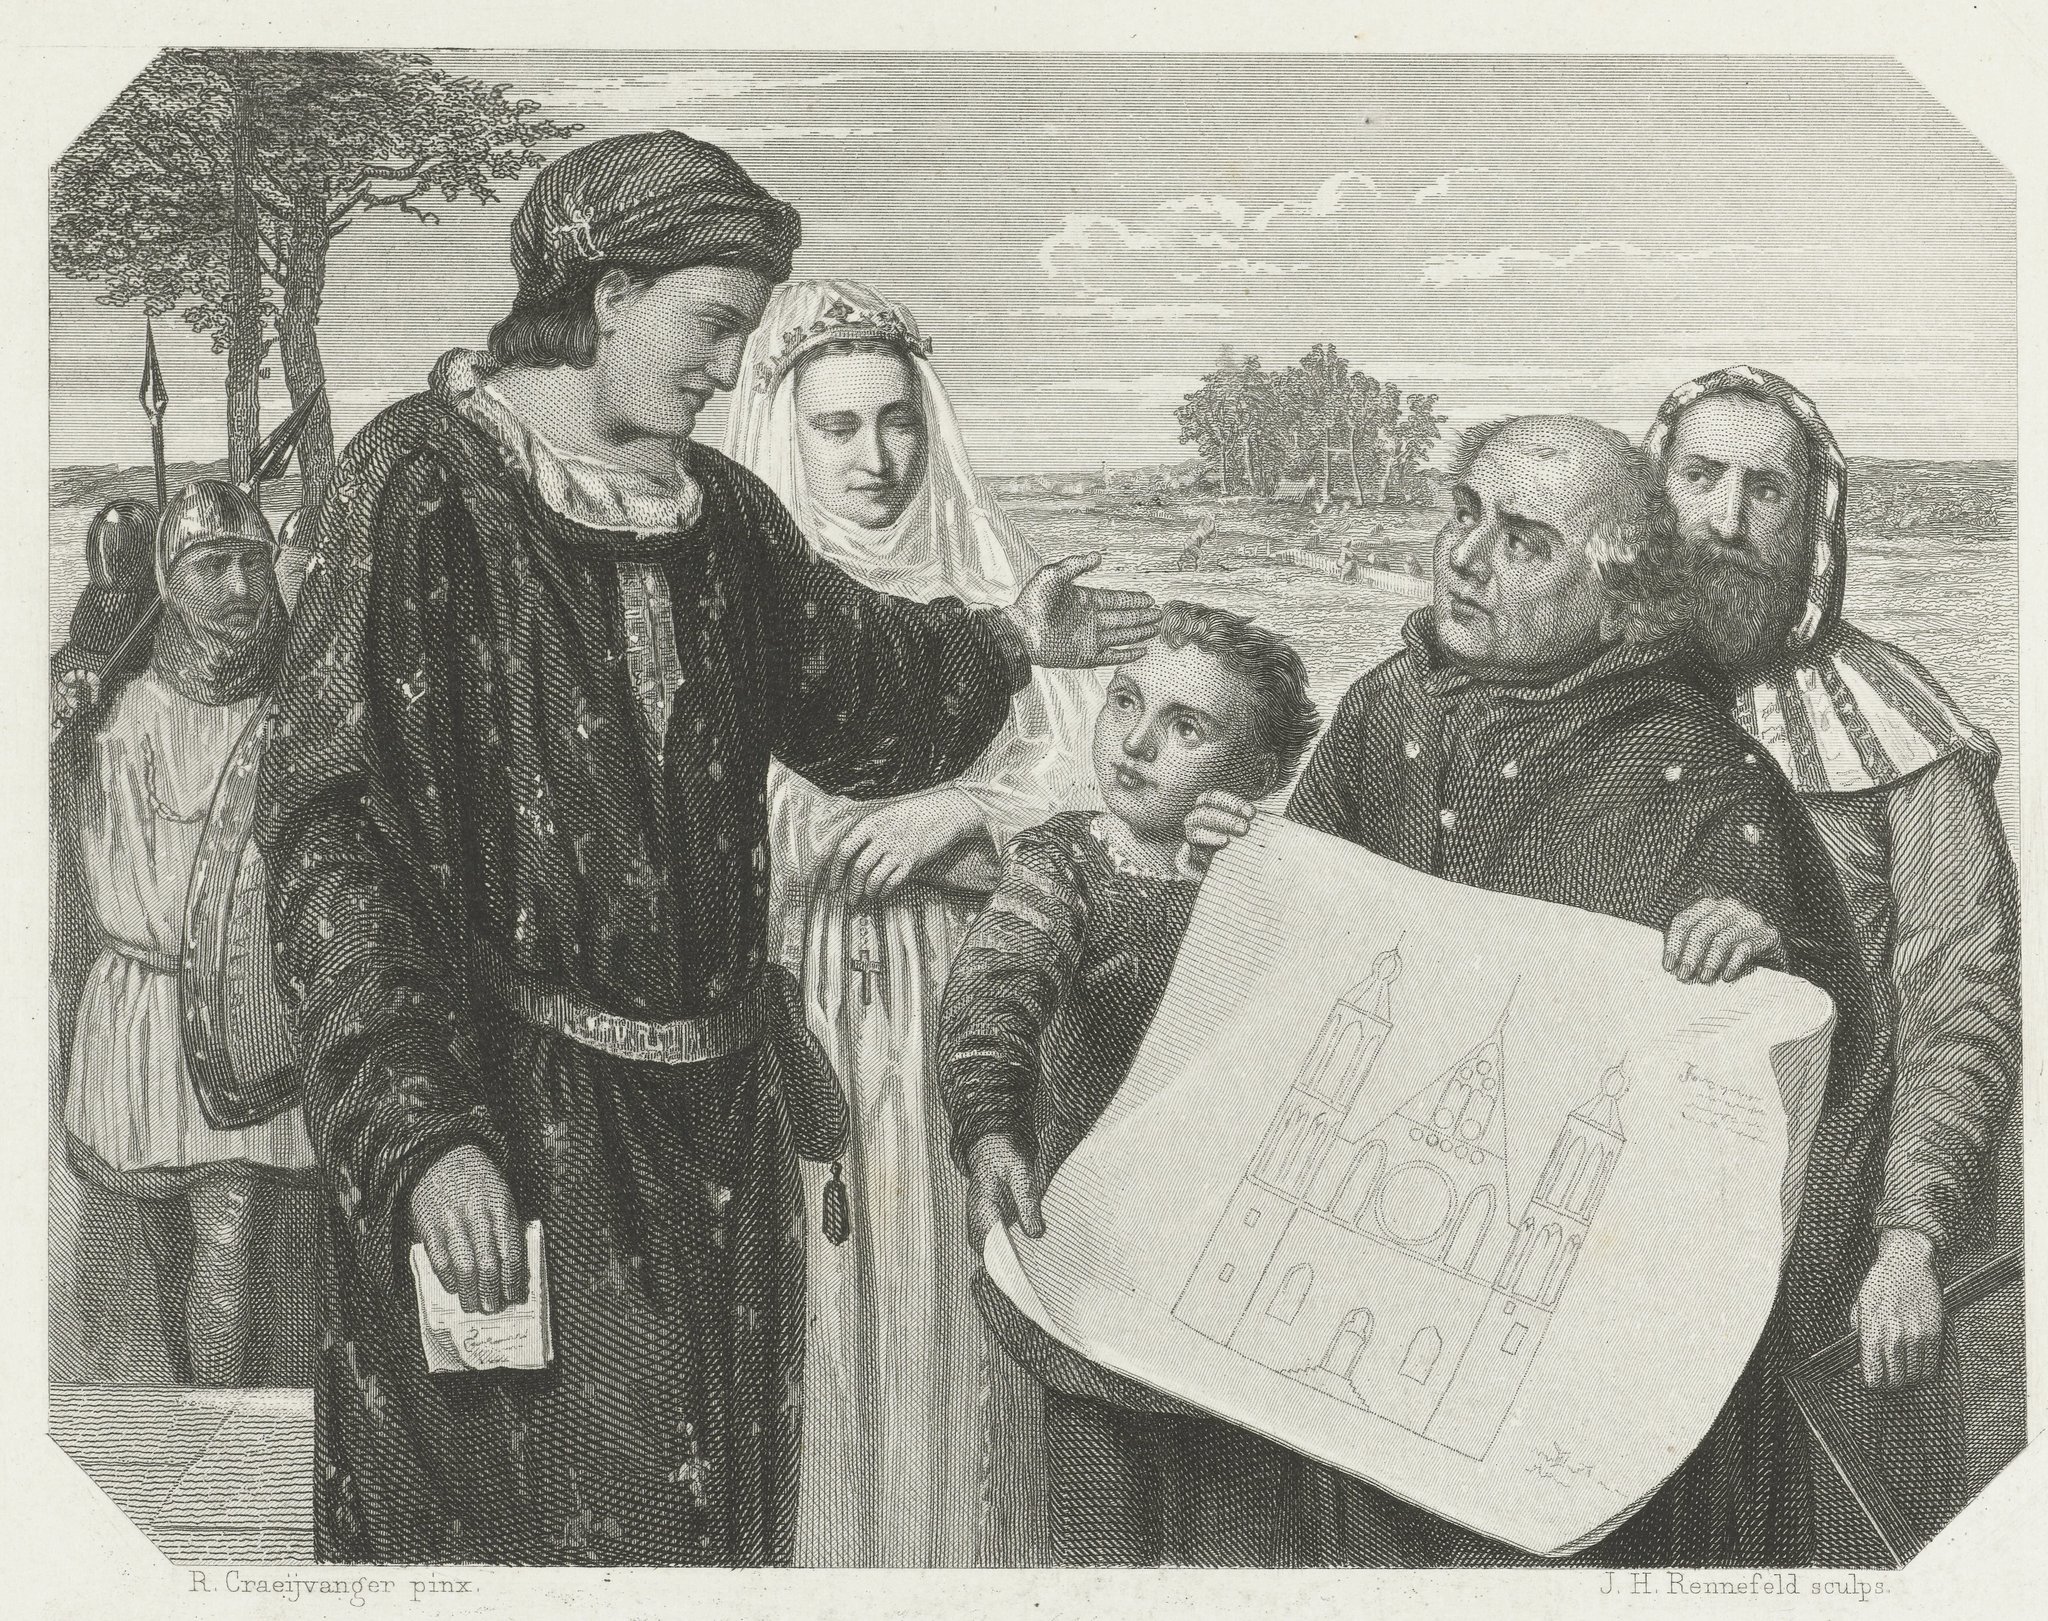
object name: history print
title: Willem II sticht het Binnenhof te 's-Gravenhage, ca. 1250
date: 1865-1870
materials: paper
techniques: engraving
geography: netherlands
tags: earl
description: Illustratie voor: J. van Lennep en W. Moll en J. ter Gouw, Nederlands geschiedenis en volksleven in schetsen, A.W. Sijthoff, Leiden ca. 1870. Staalgravures naar de schilderijen van de Historische Galerij der Maatschappij Arti en Amicitiae.